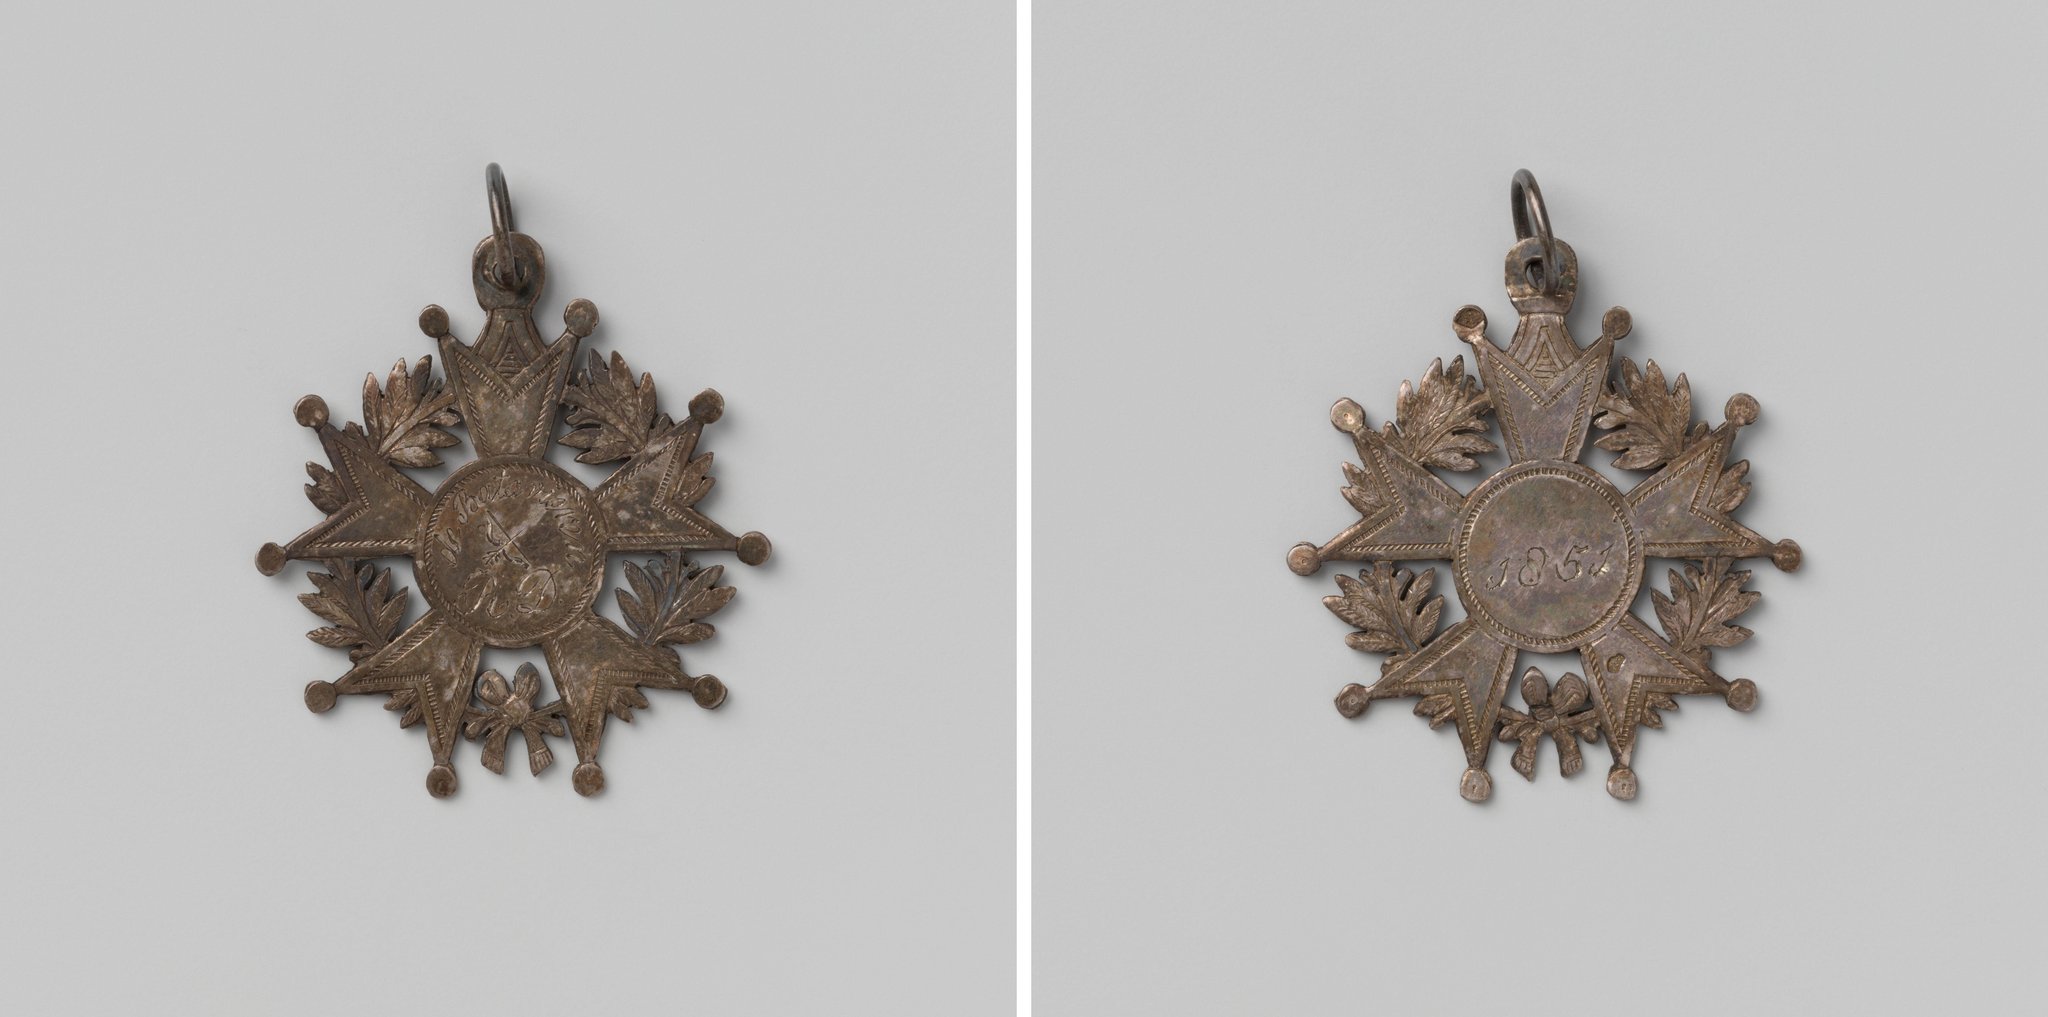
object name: insignia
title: Schuttersvereniging 'de Batavieren'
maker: Anonymous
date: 1851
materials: silver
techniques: engraving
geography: netherlands